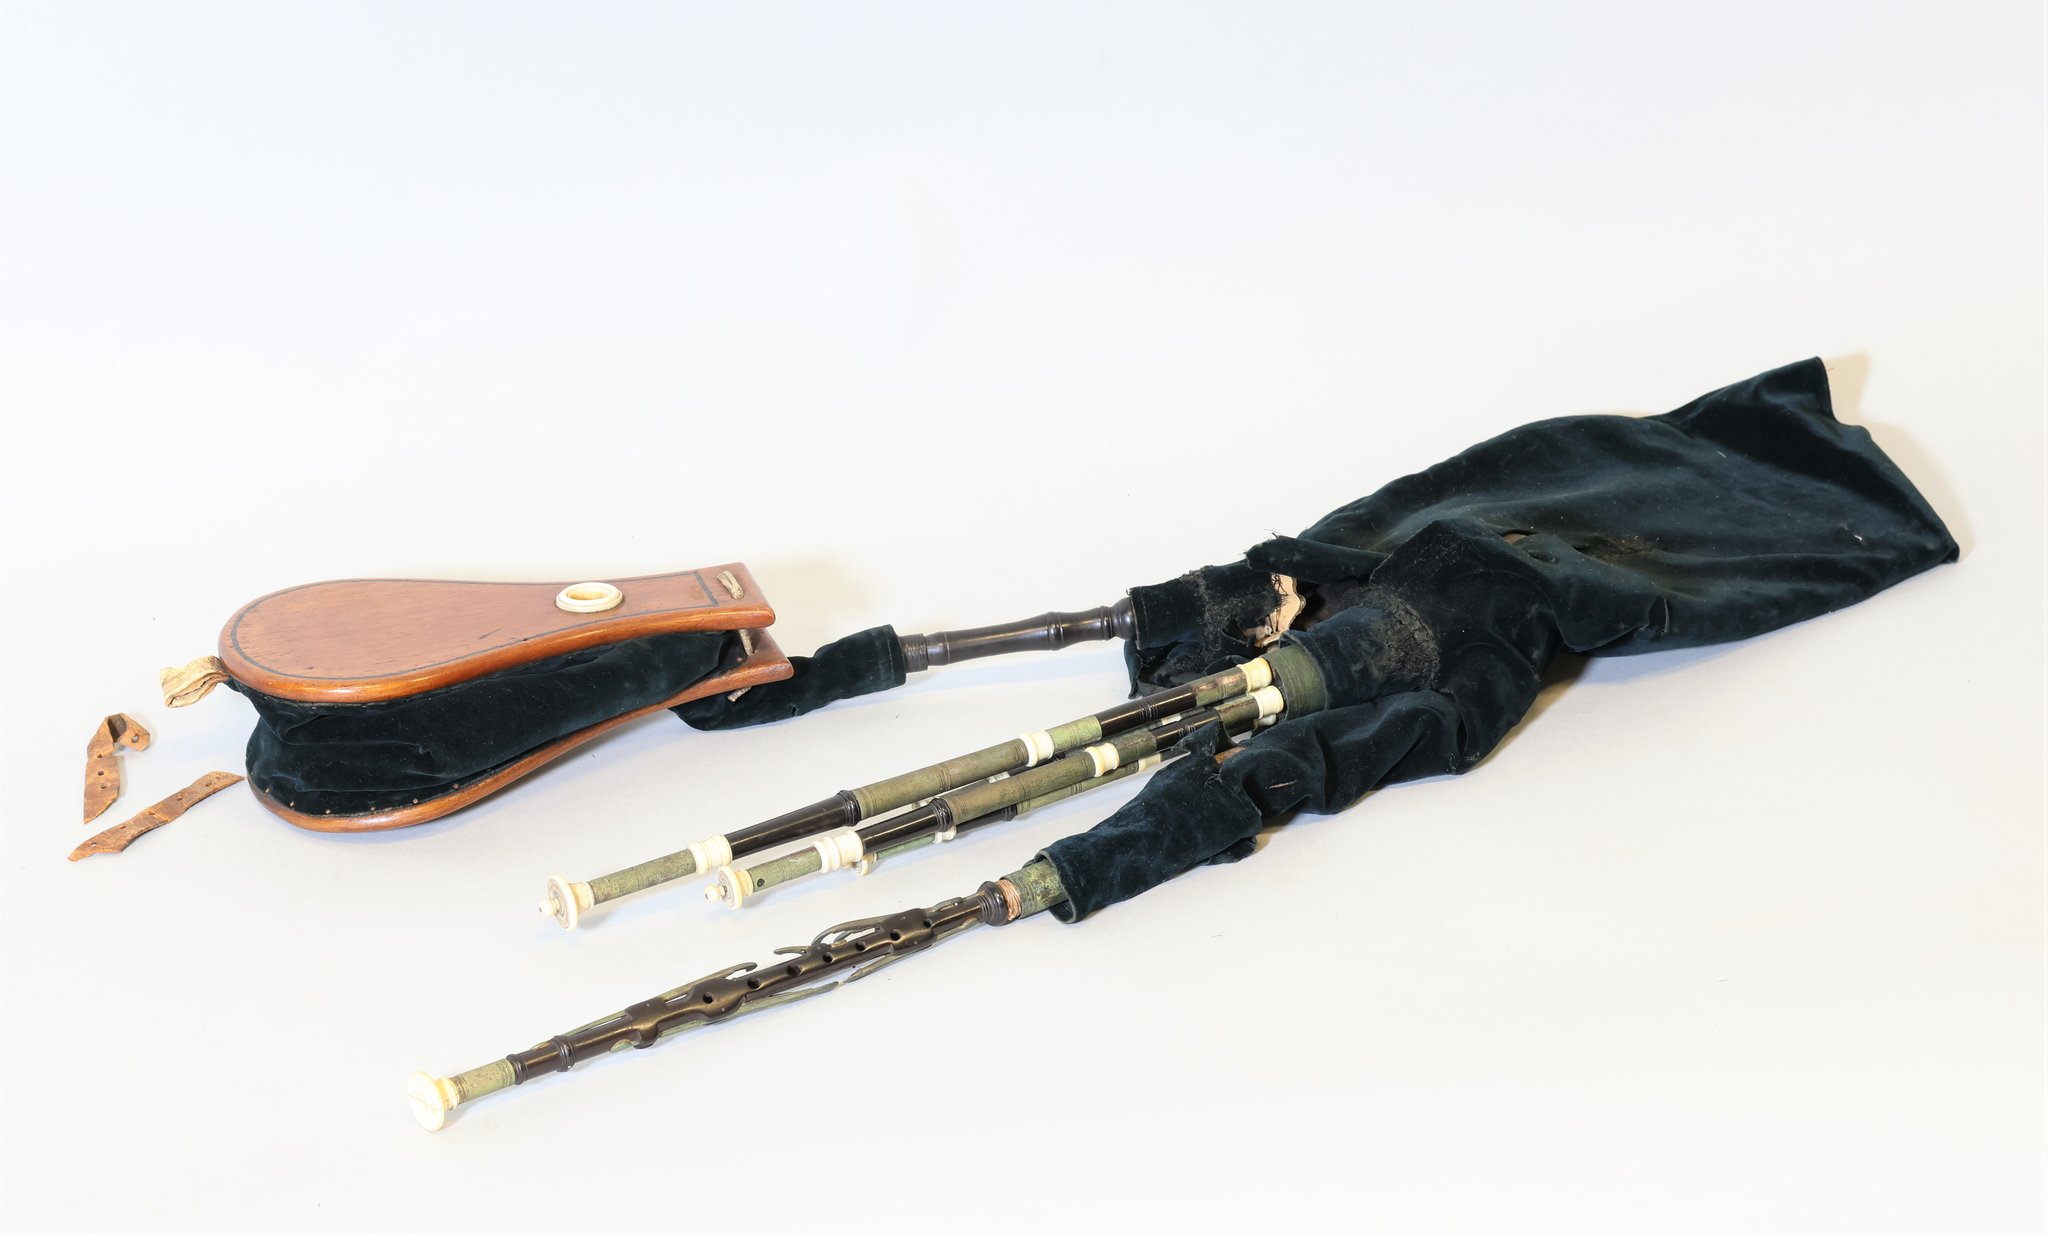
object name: northumbrian small pipe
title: Northumbrian Small-Pipe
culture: scottish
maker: john center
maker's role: maker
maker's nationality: scottish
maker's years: 1870-1913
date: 1867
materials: brass, ivory, leather, wood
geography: scotland